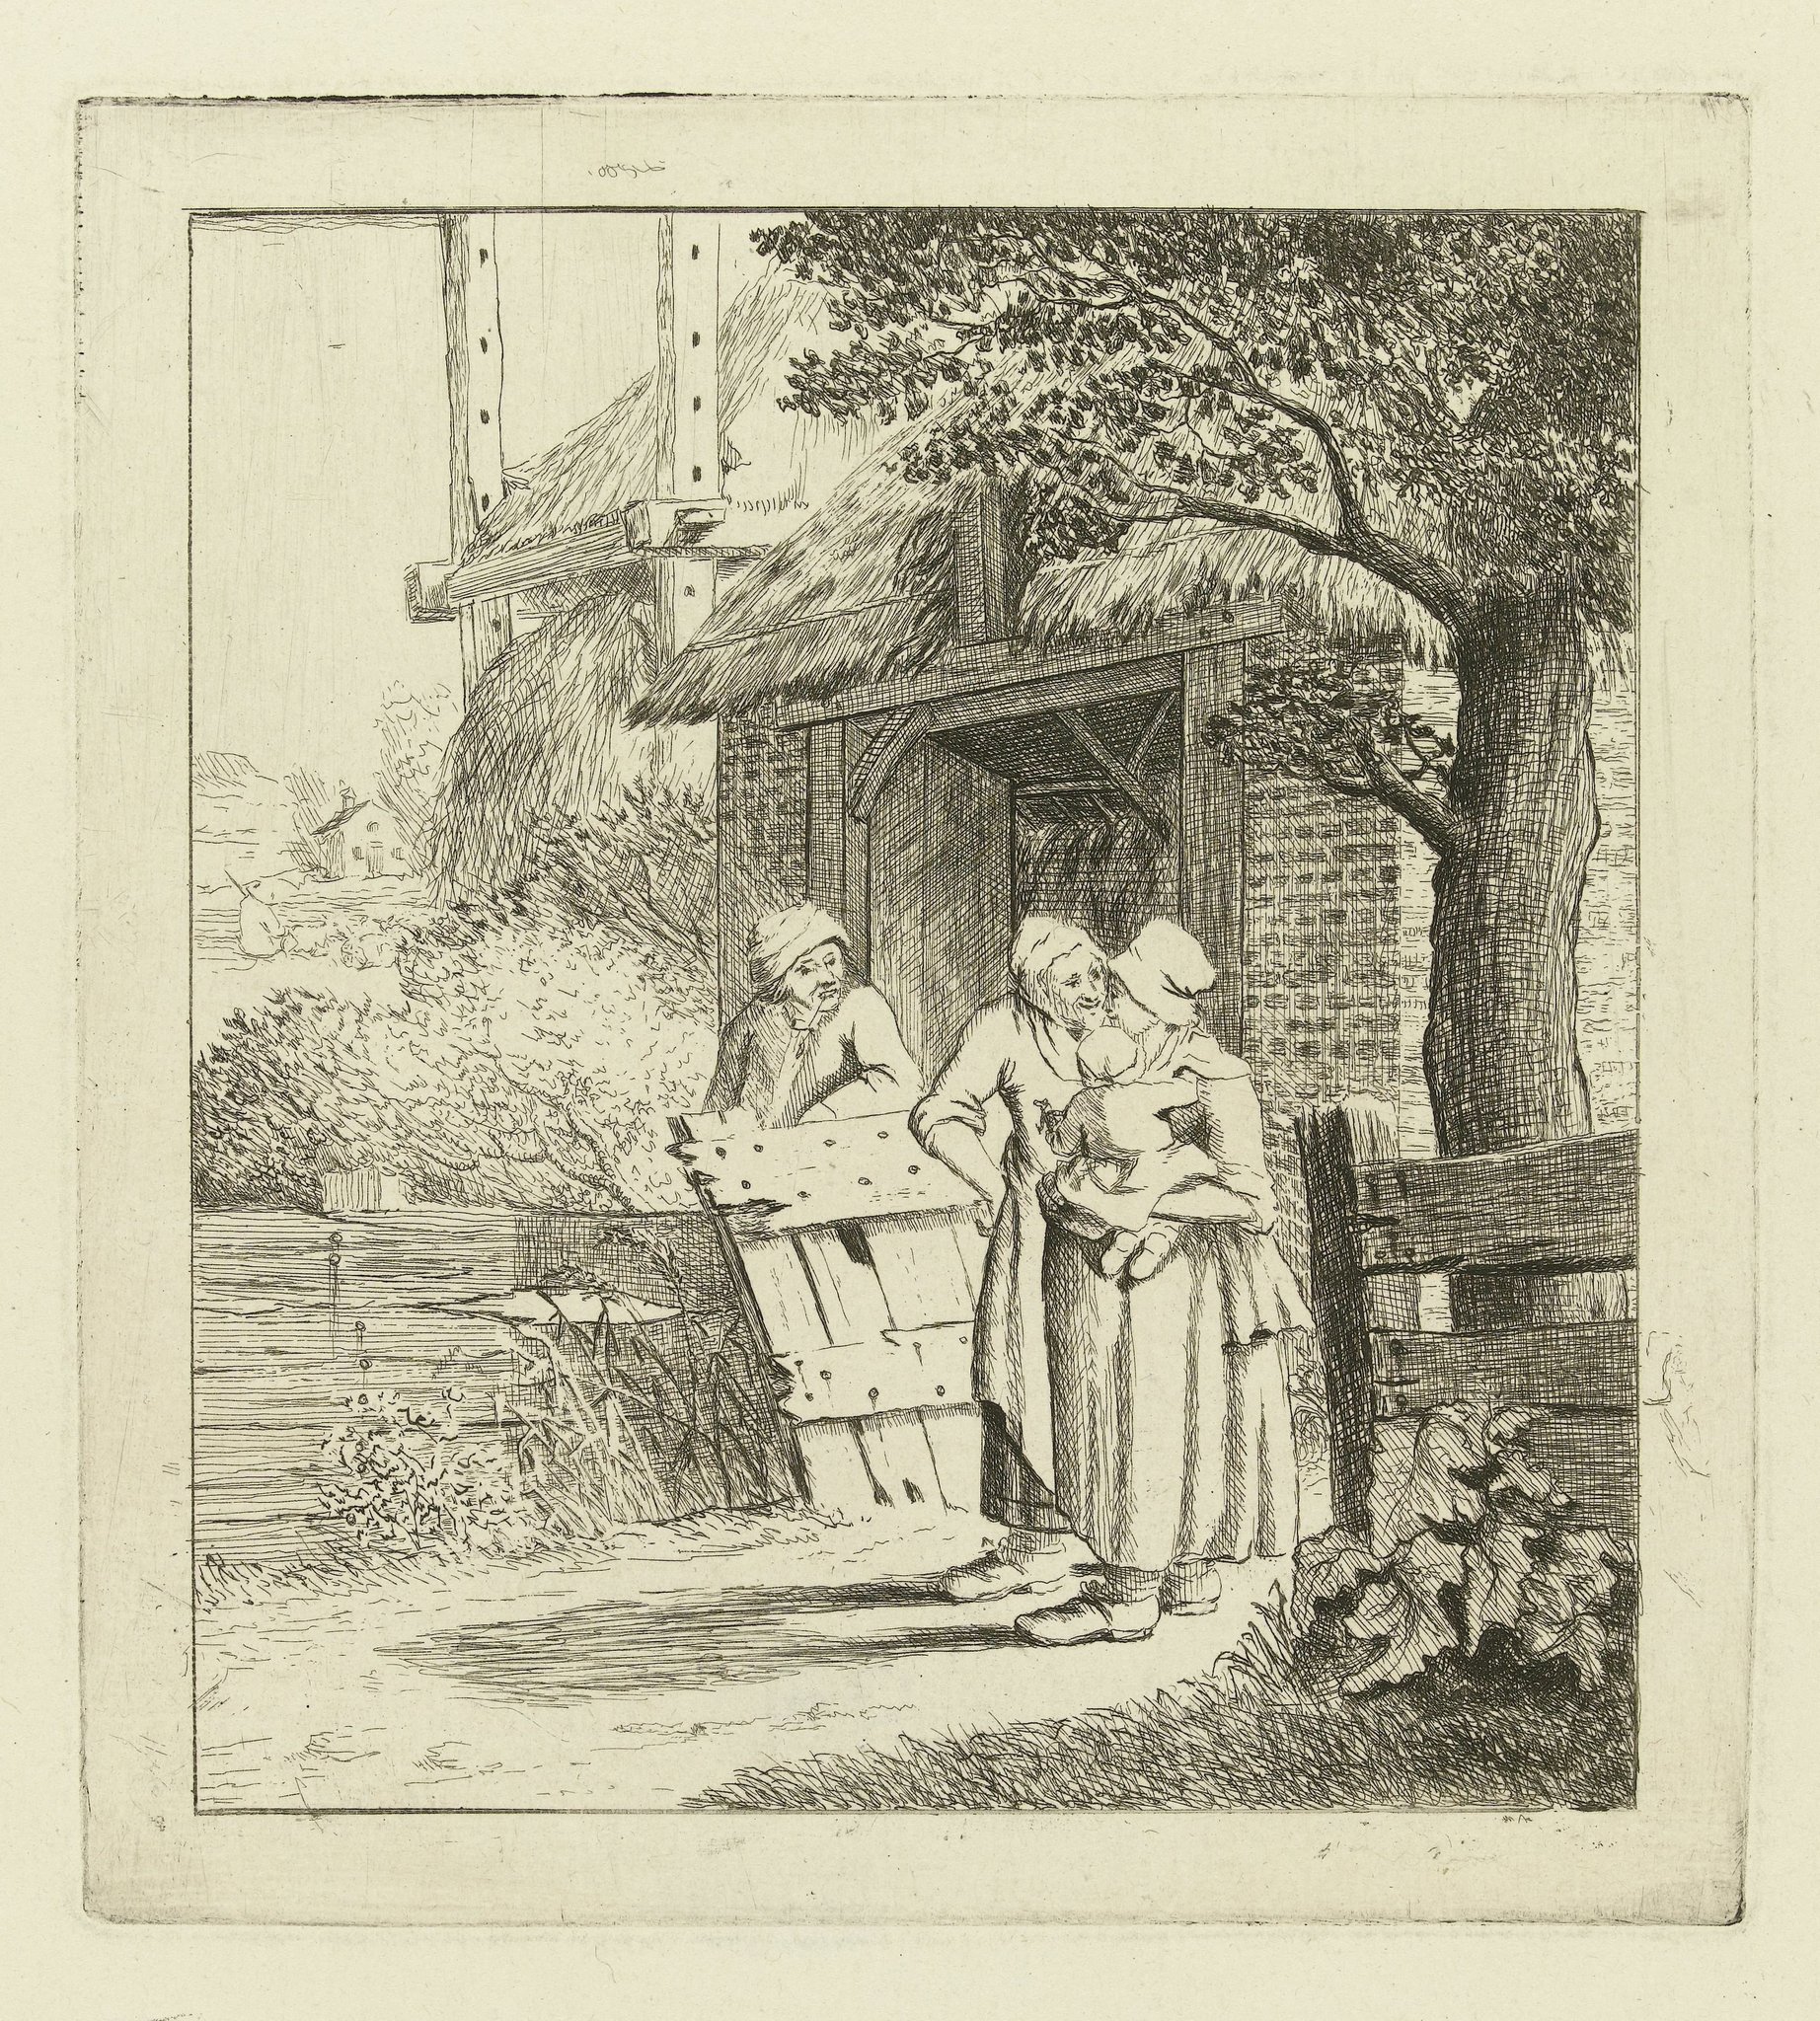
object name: print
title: Twee vrouwen en een man voor een boerderij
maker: marie lambertine coclers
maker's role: conservator, draughtsman, print maker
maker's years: 1761-1815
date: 1776-1815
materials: paper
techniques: drypoint, etching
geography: amsterdam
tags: hay-stack, conversation, dialogue; conversation piece, farm (building)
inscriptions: collector's mark: Lugt 2228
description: Bij het hek van een boerderij staan een oude vrouw en een jonge vrouw met een kind op haar arm te kletsen. Voor de deur van het huis staat een boer met een pijp. Achter de boerderij is een deel van een grote hooistapel te zien.